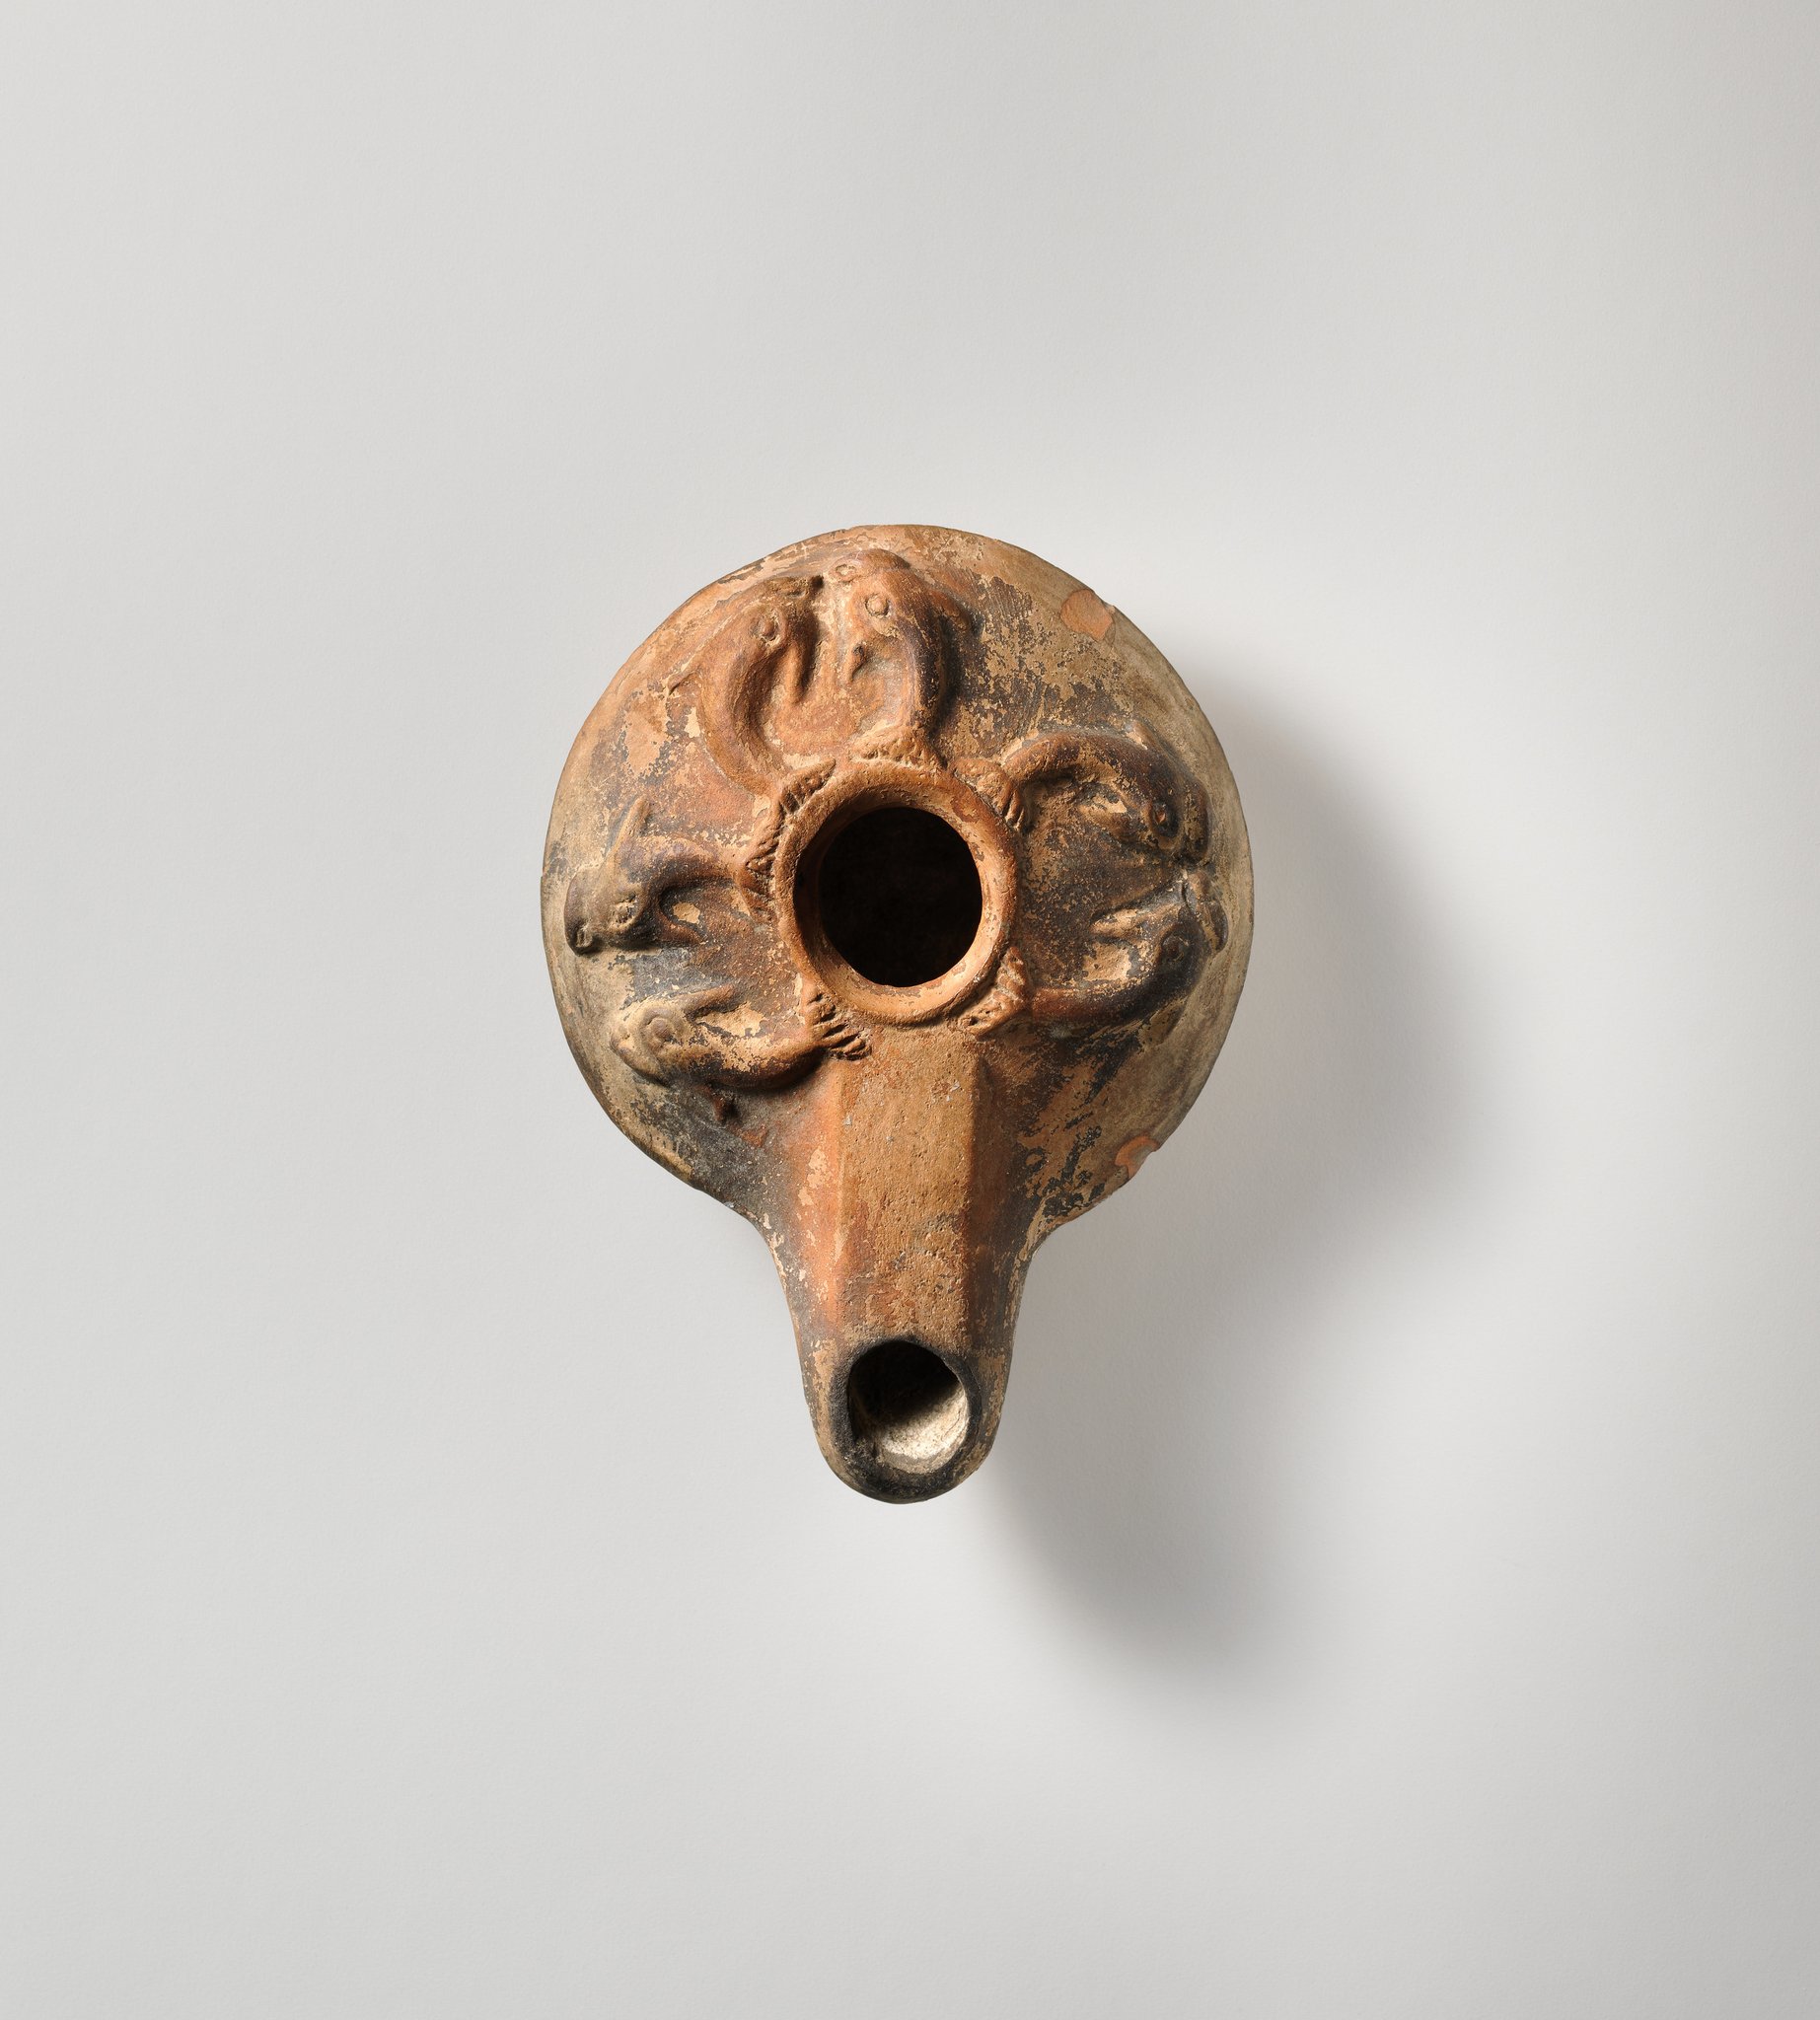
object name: lamp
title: Terracotta oil lamp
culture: greek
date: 167-1 BCE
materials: terracotta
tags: dolphins